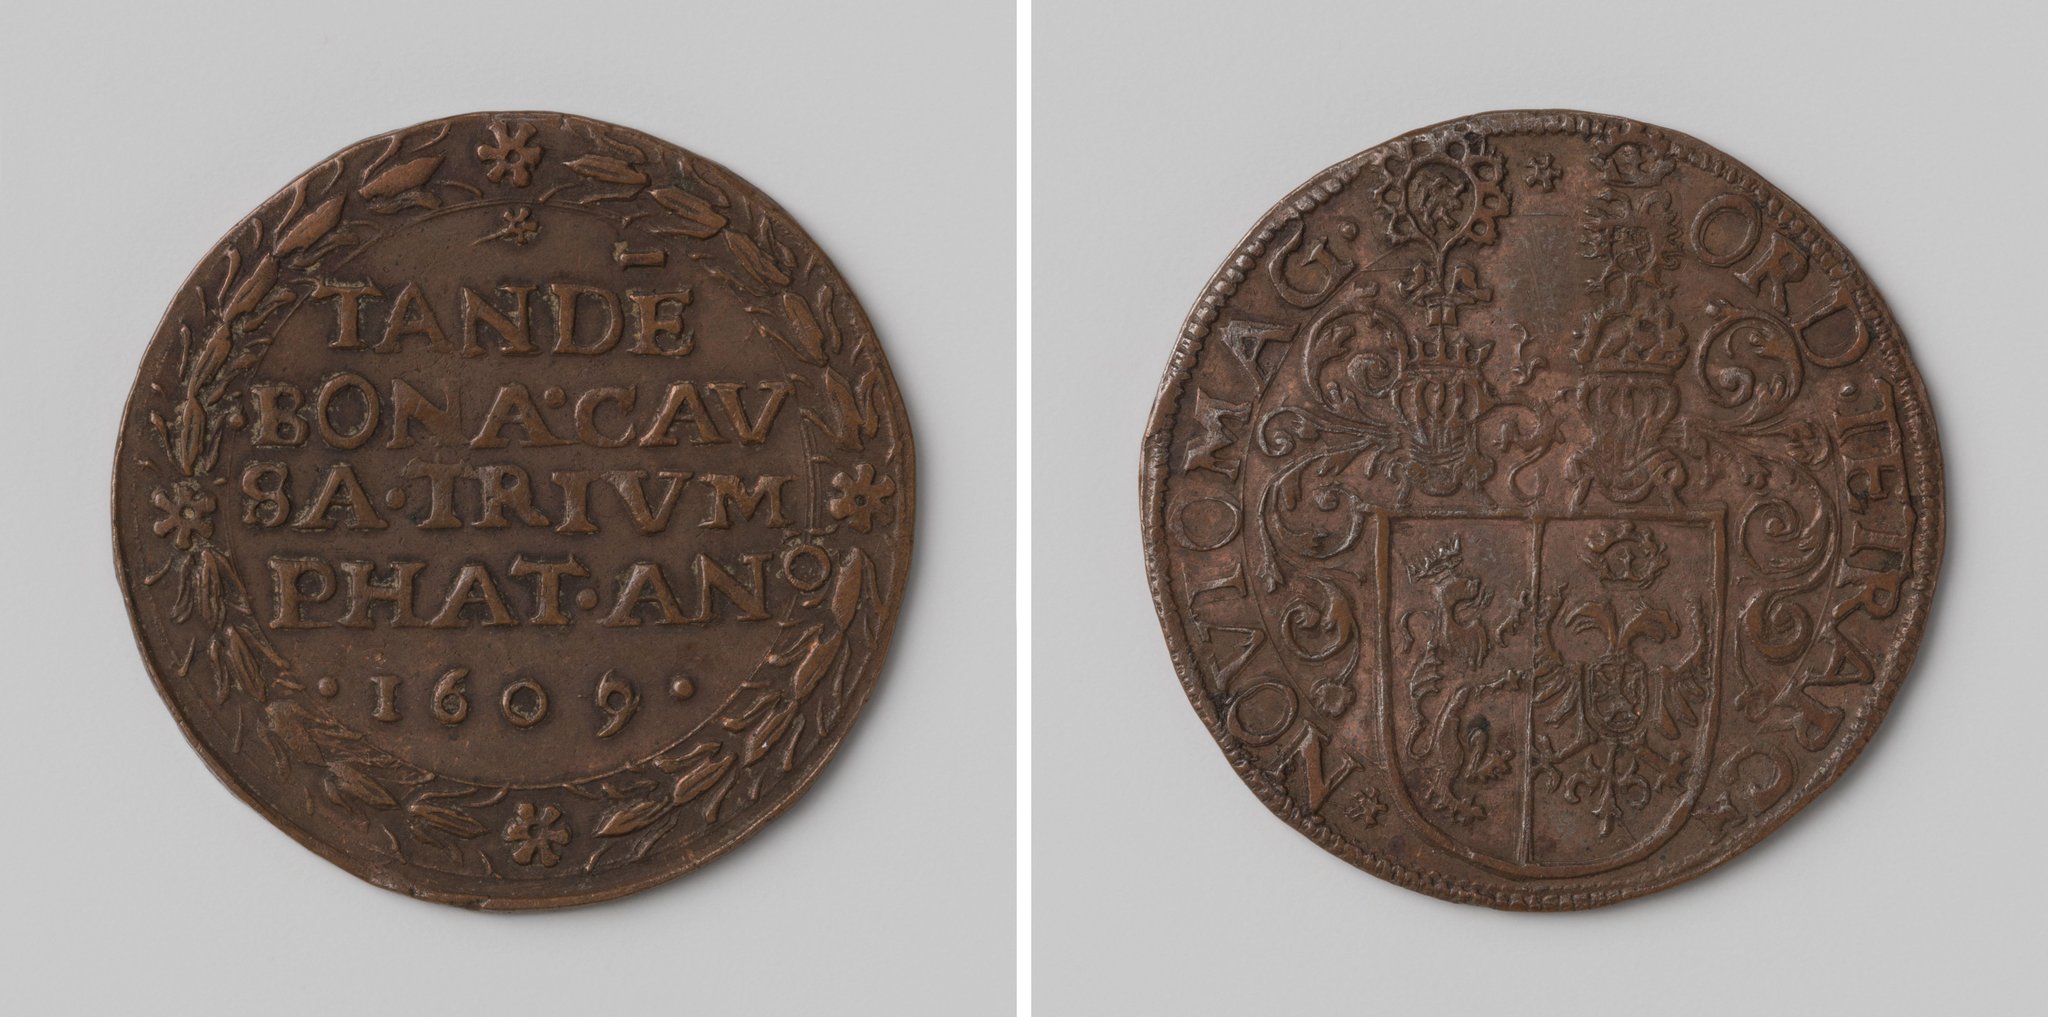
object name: jeton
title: Sluiting van het Twaalfjarig Bestand tussen de Republiek en Spanje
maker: Anonymous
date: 1609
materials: copper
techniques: striking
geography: netherlands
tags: nijmegen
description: Koperen penning. Voorzijde: opschrift binnen krans van olijftakken. Keerzijde: wapenschild onder twee gekroonde helmen binnen omschrift.